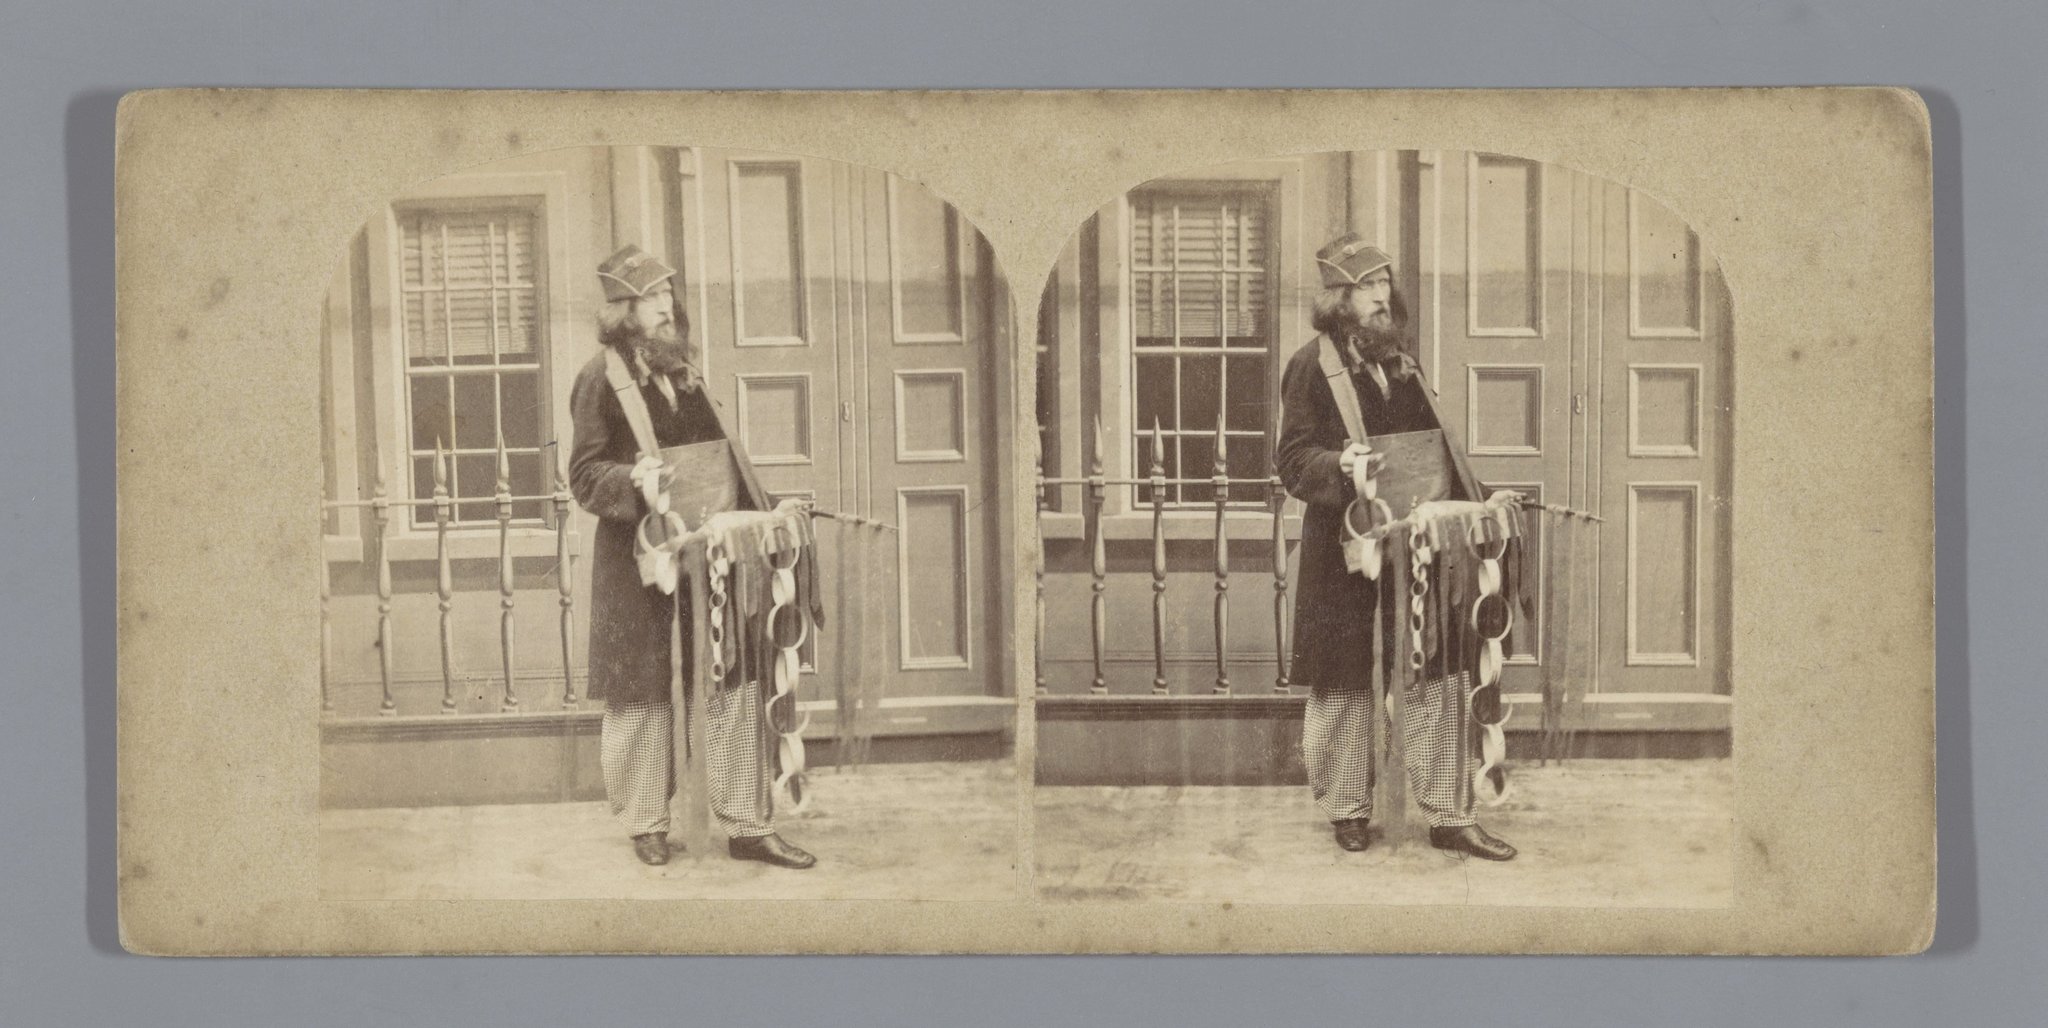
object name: stereograph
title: Straatverkoper van papieren slingers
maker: Anonymous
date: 1850-1880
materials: cardboard, photographic support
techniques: albumen print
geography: europe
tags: street-trader, europe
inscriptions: number: ‘42’, inscription: ‘vg 75’